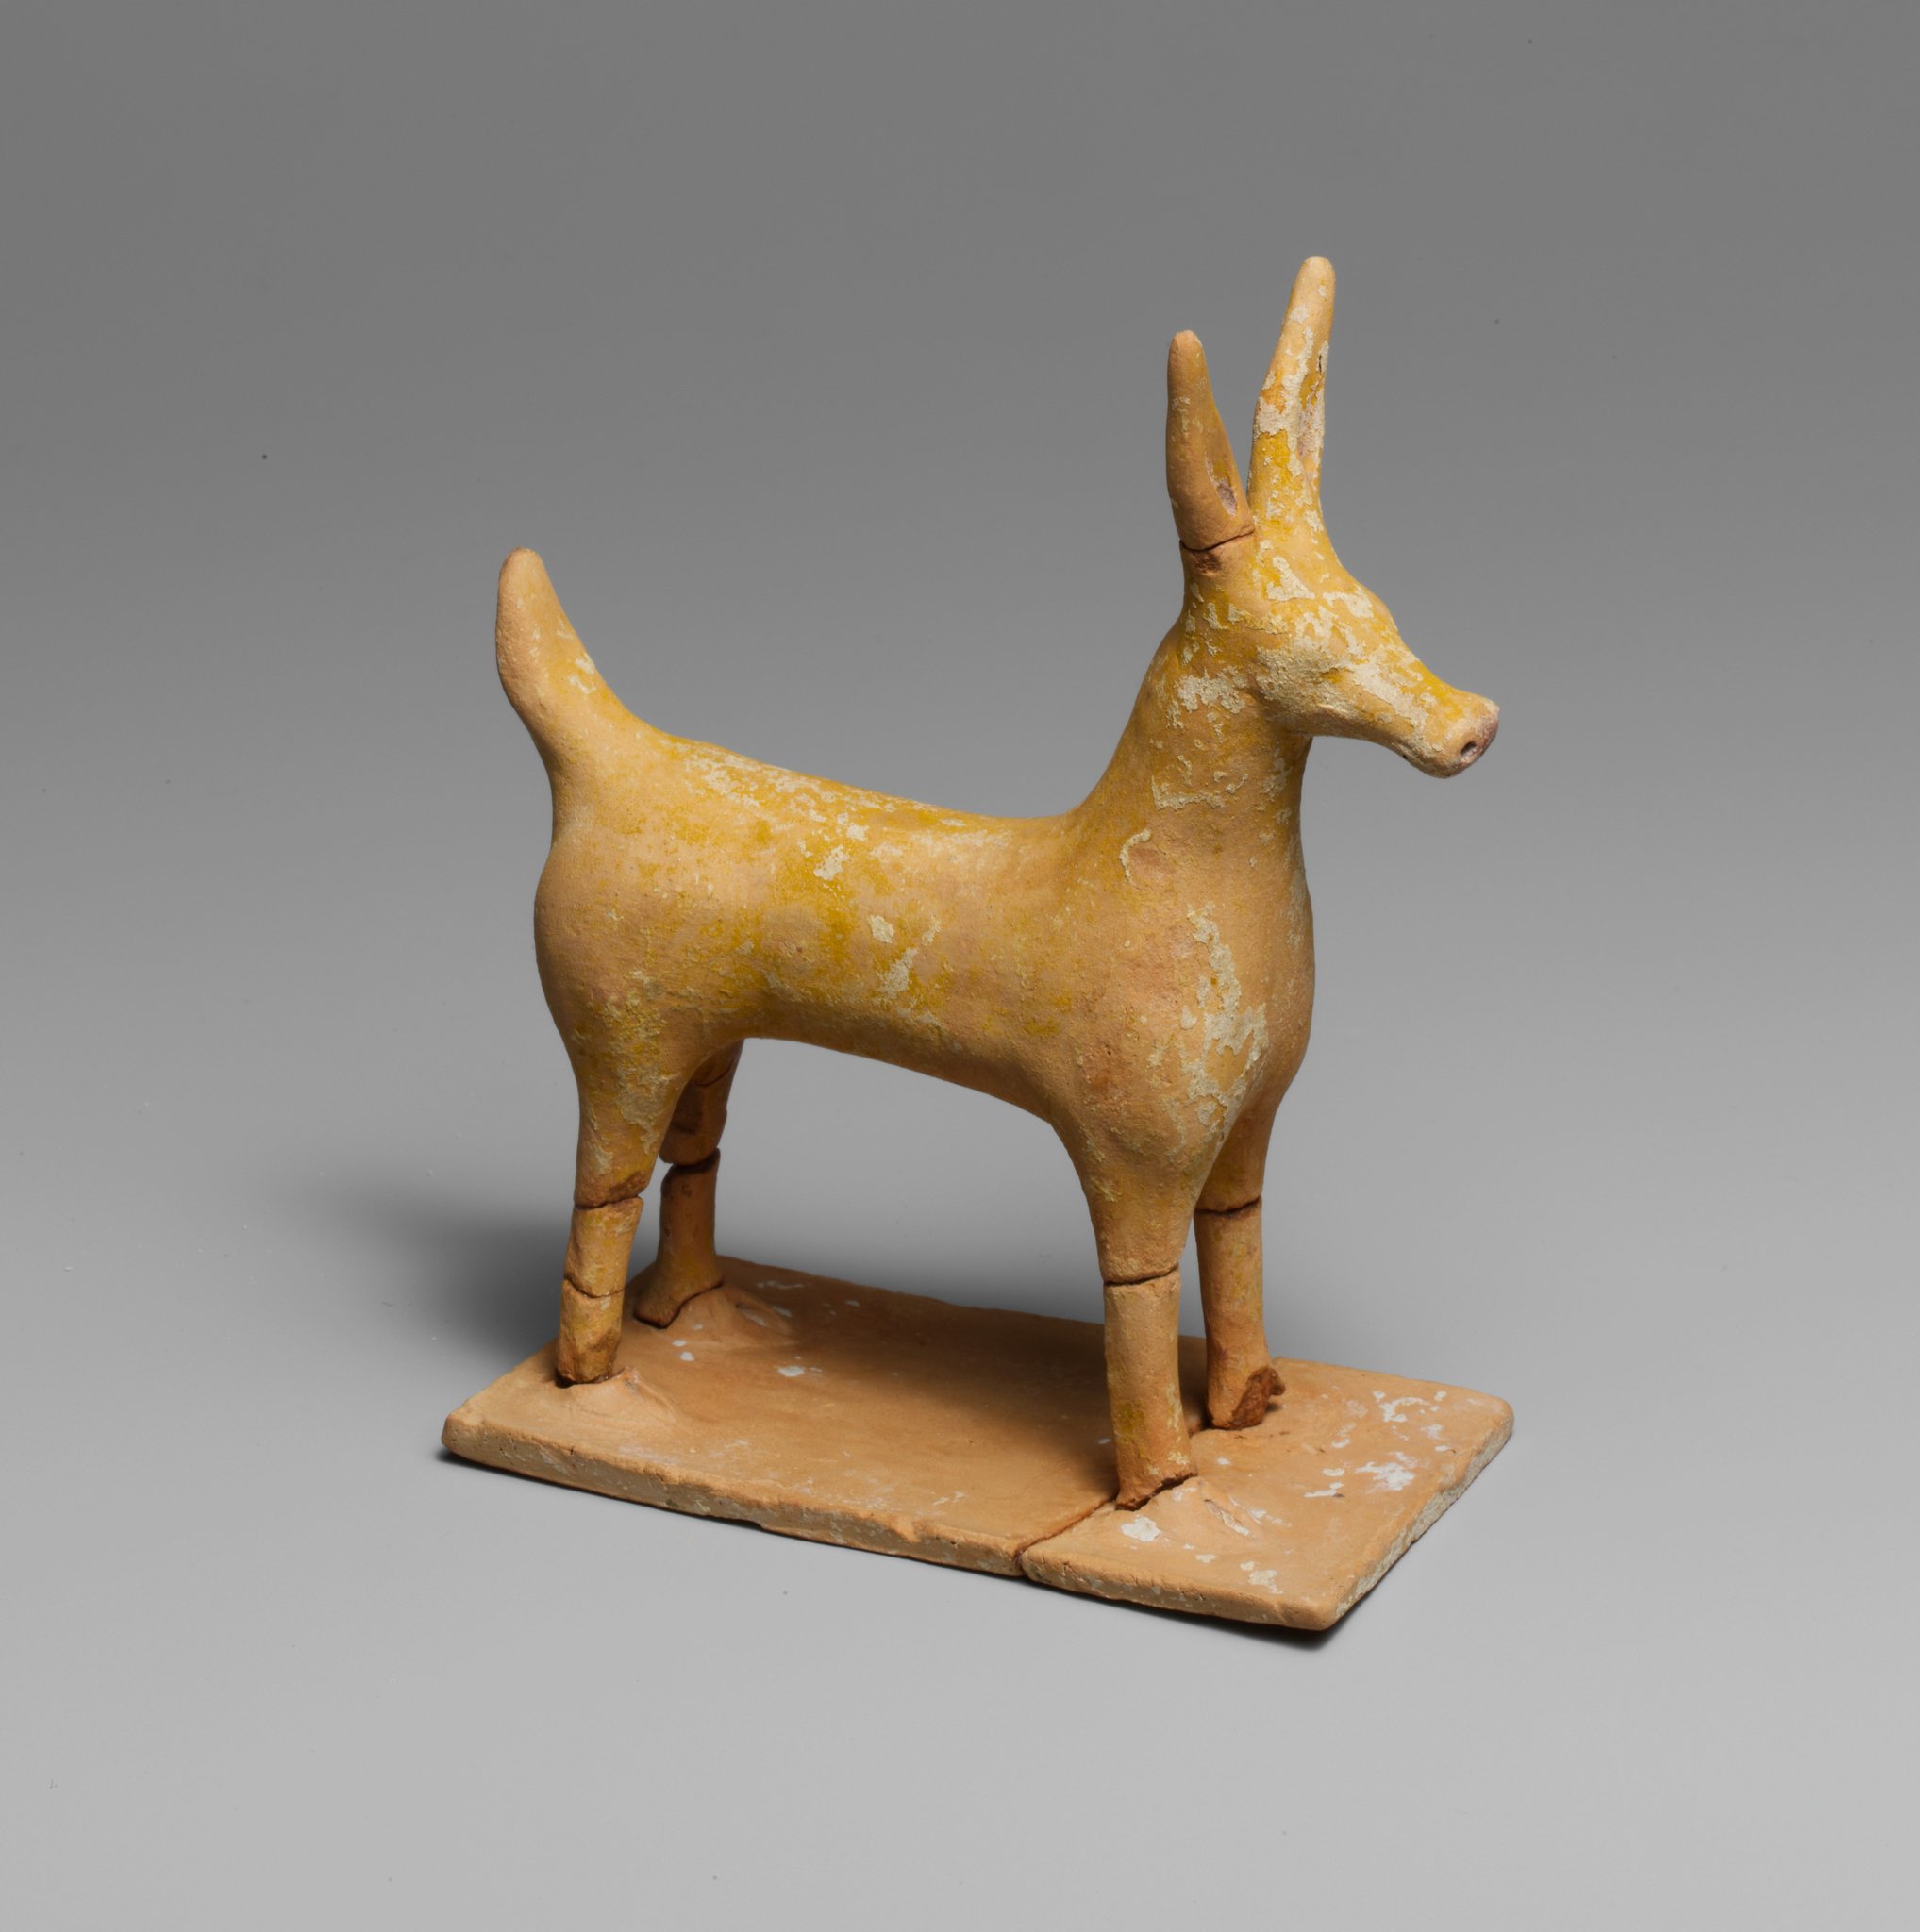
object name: statuette of a deer doe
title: Terracotta statuette of a deer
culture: greek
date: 534-501 BCE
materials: terracotta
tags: deer